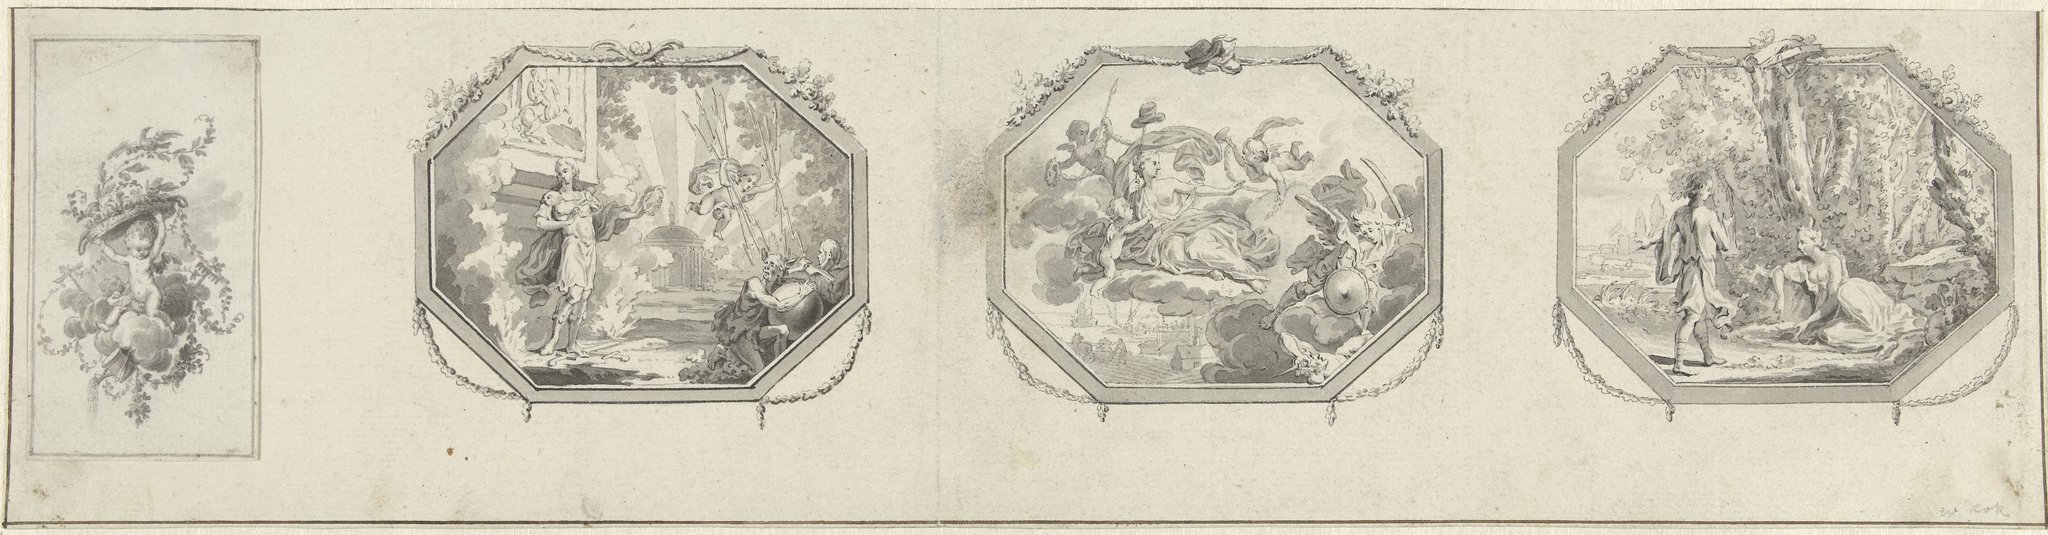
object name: drawing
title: Ontwerpen voor decoraties van snuifdozen: vier allegorische voorstellingen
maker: willem kok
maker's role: draughtsman, print maker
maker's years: 1761-1807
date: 1771-1807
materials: ink, paper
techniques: brush, pen